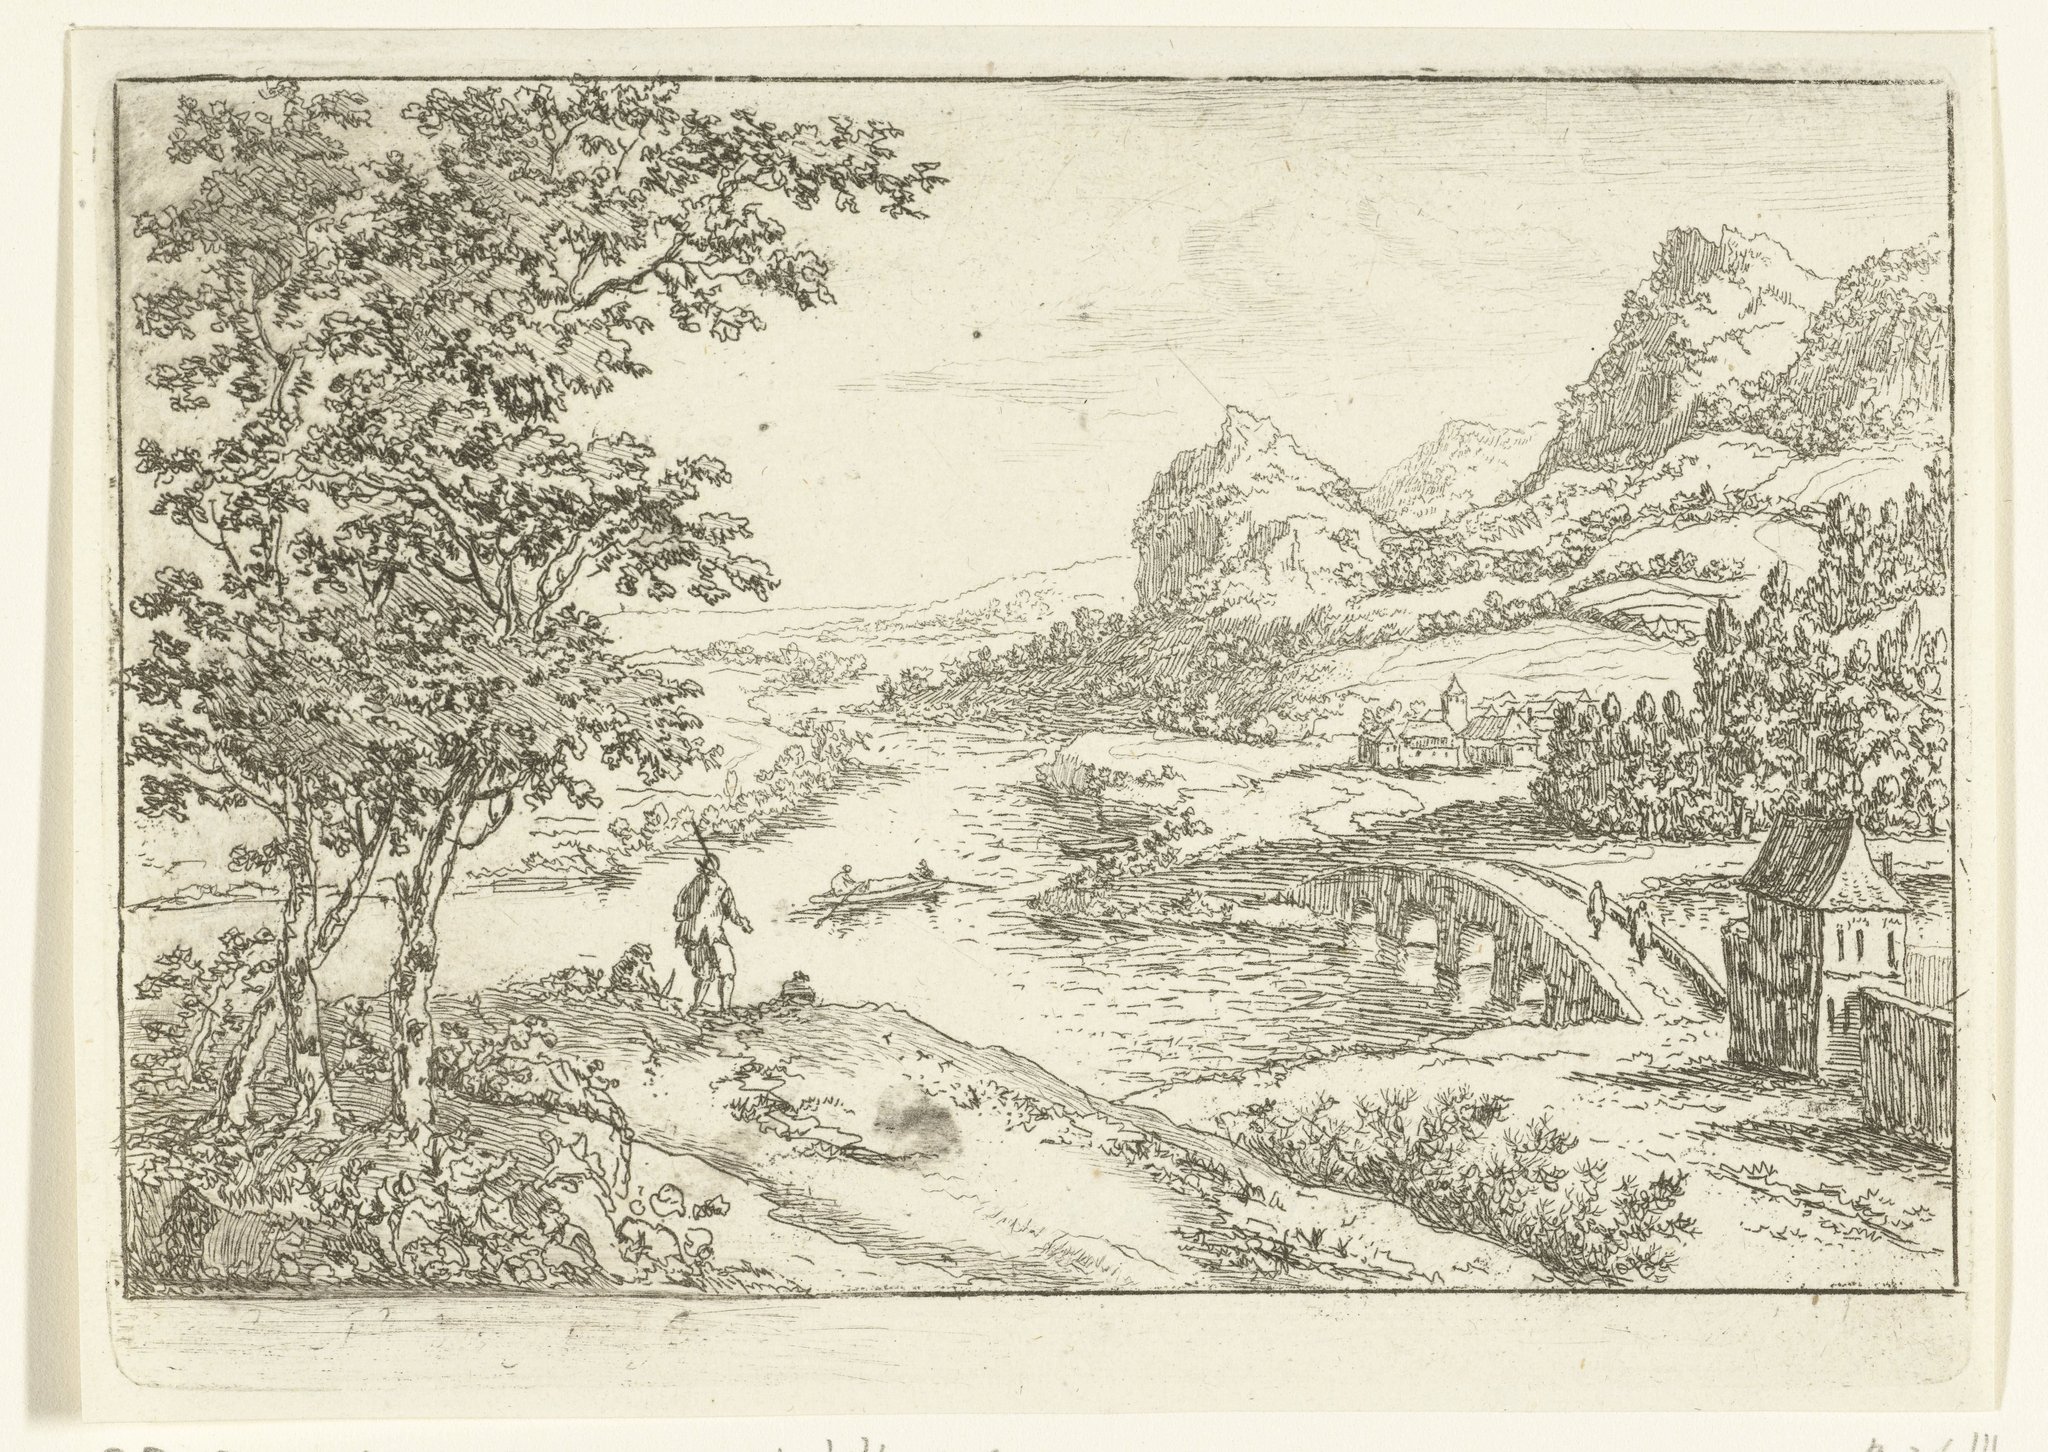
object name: print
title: Stenen brug bij een riviersplitsing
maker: jan van almeloveen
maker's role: draughtsman, print maker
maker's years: 1652-1683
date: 1662-1683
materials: paper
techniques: etching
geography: netherlands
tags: river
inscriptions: collector's mark: Lugt 2228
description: Als boekillustratie gebruikt in: Spiegel der natuur en school der teekenkunde, Amsterdam, J.S. van Esveldt-Holtrop, c. 1780 (RMAB 318 G 10)